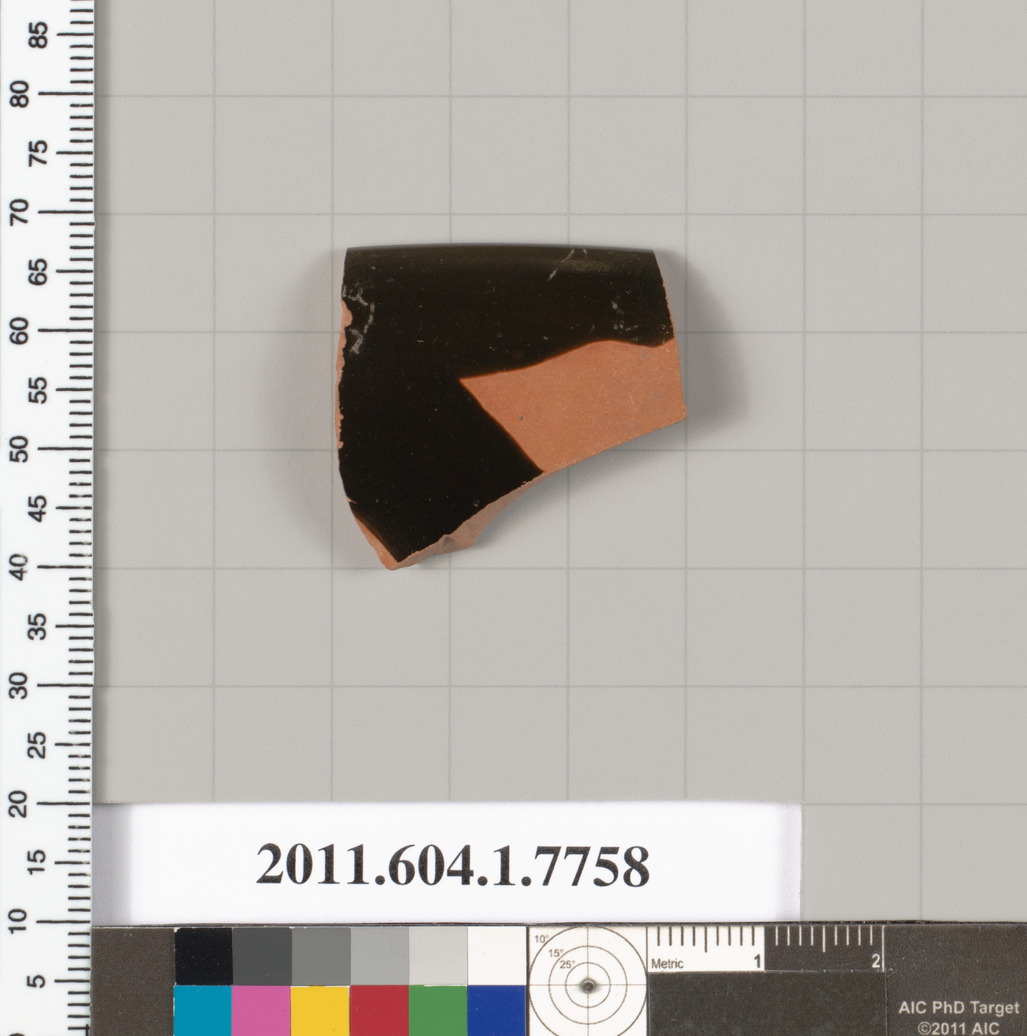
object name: kylix fragment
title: Terracotta rim fragment of a kylix (drinking cup)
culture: greek, attic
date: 475-451 BCE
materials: terracotta